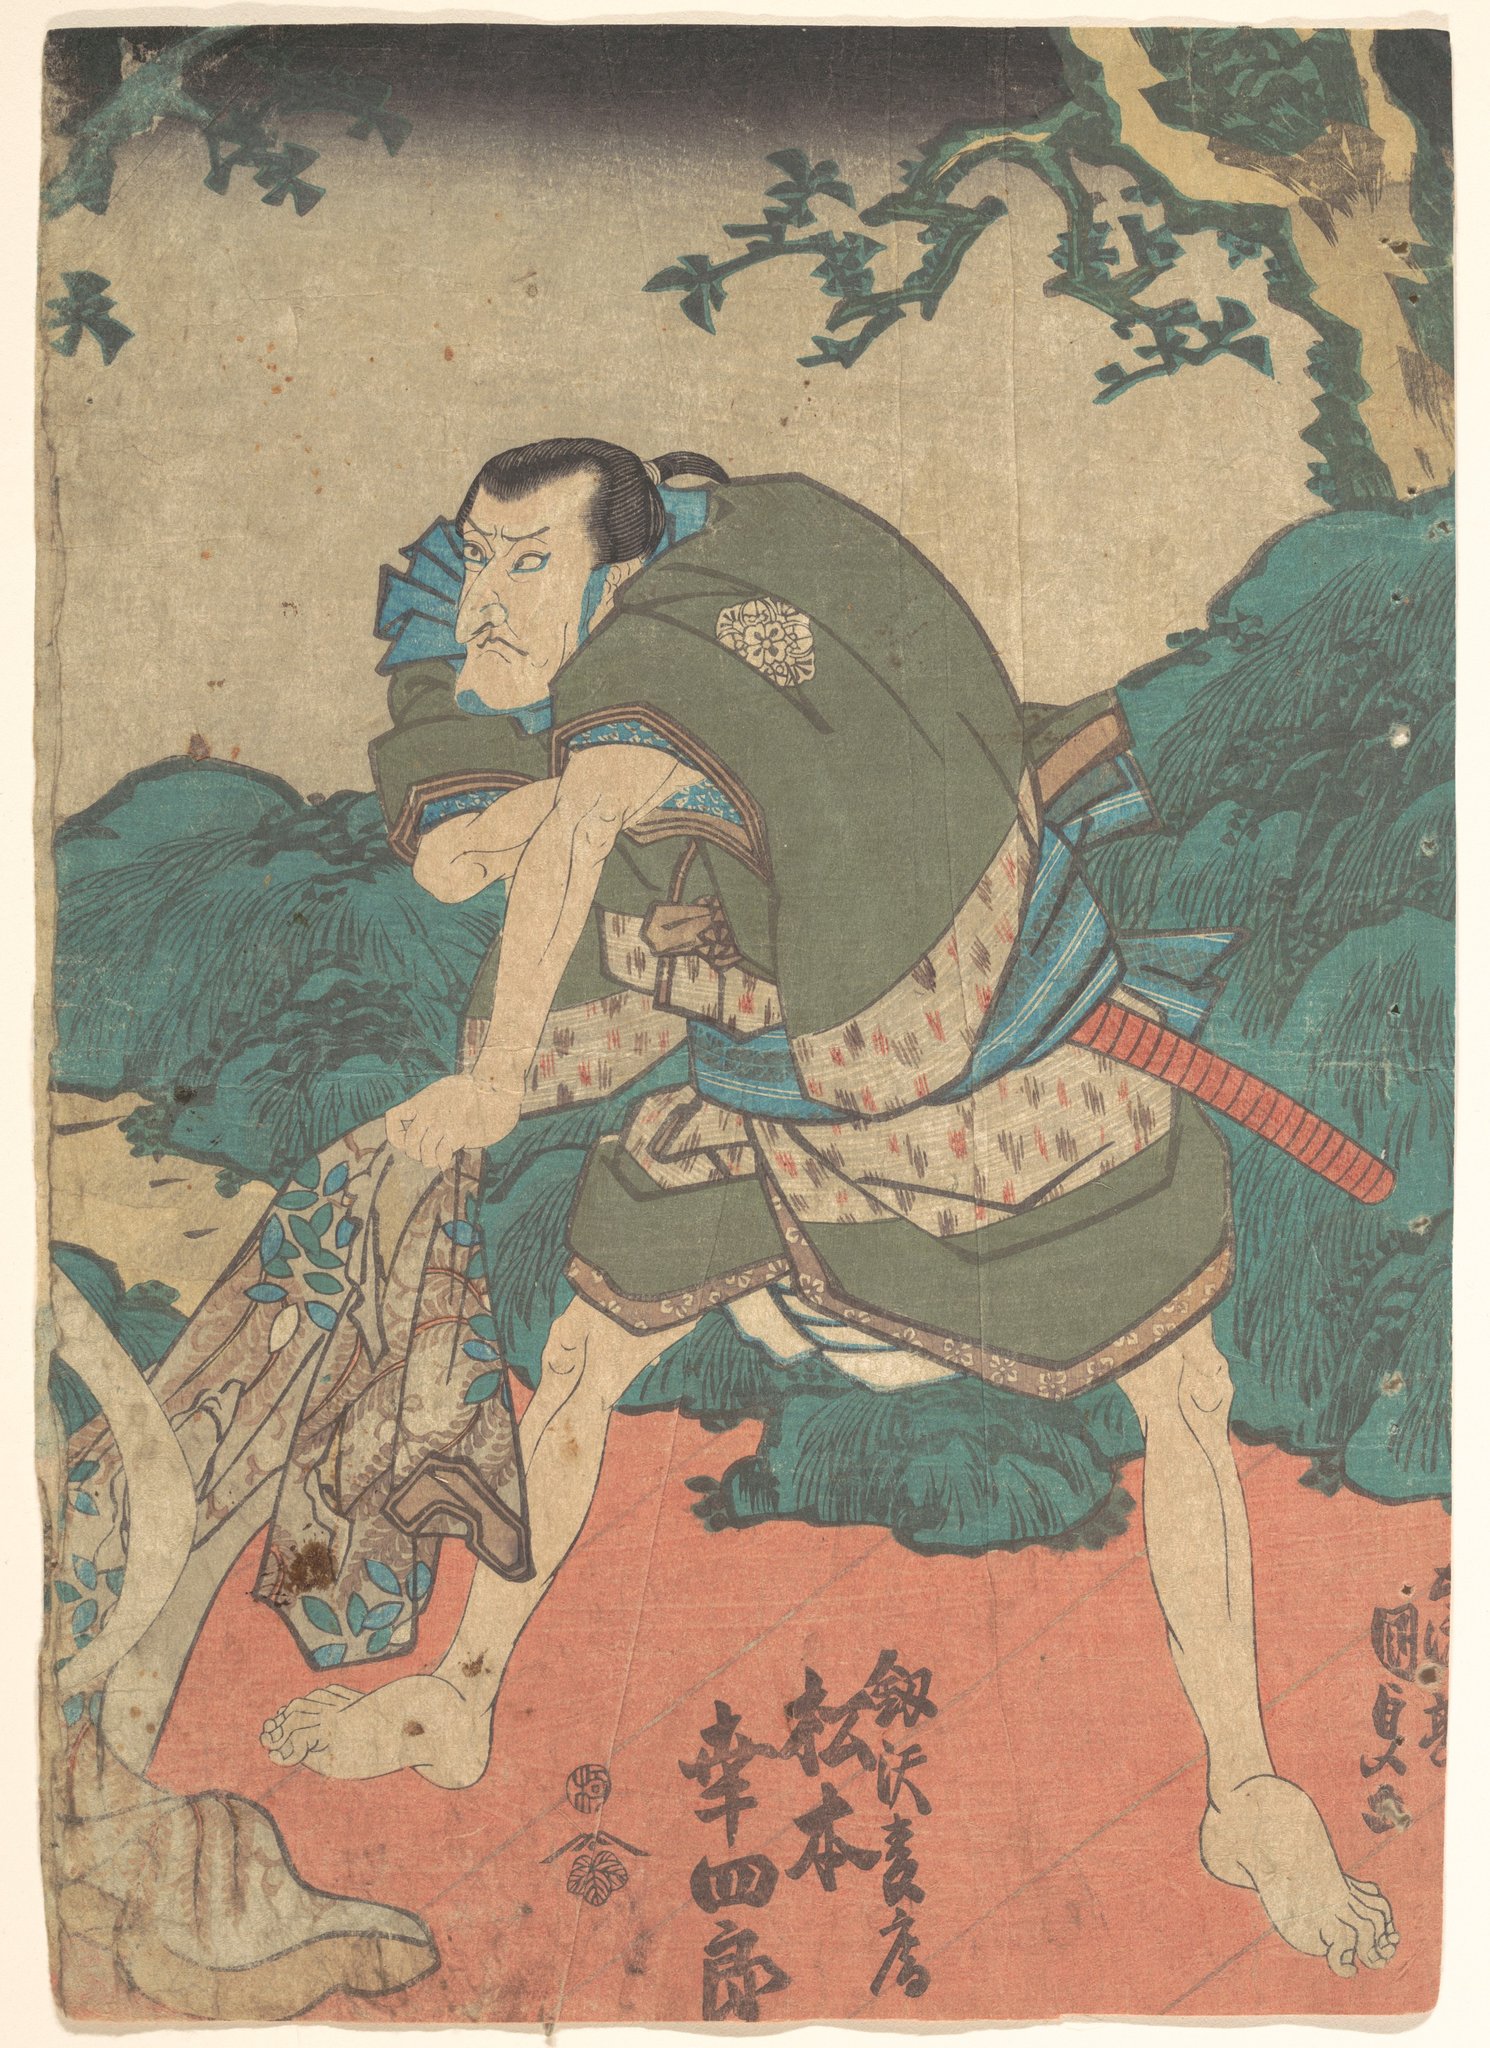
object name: print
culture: japanese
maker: utagawa kunisada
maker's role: artist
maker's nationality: japanese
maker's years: 1786-1864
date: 1801-1900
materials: ink, paper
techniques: woodblock print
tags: men,trees